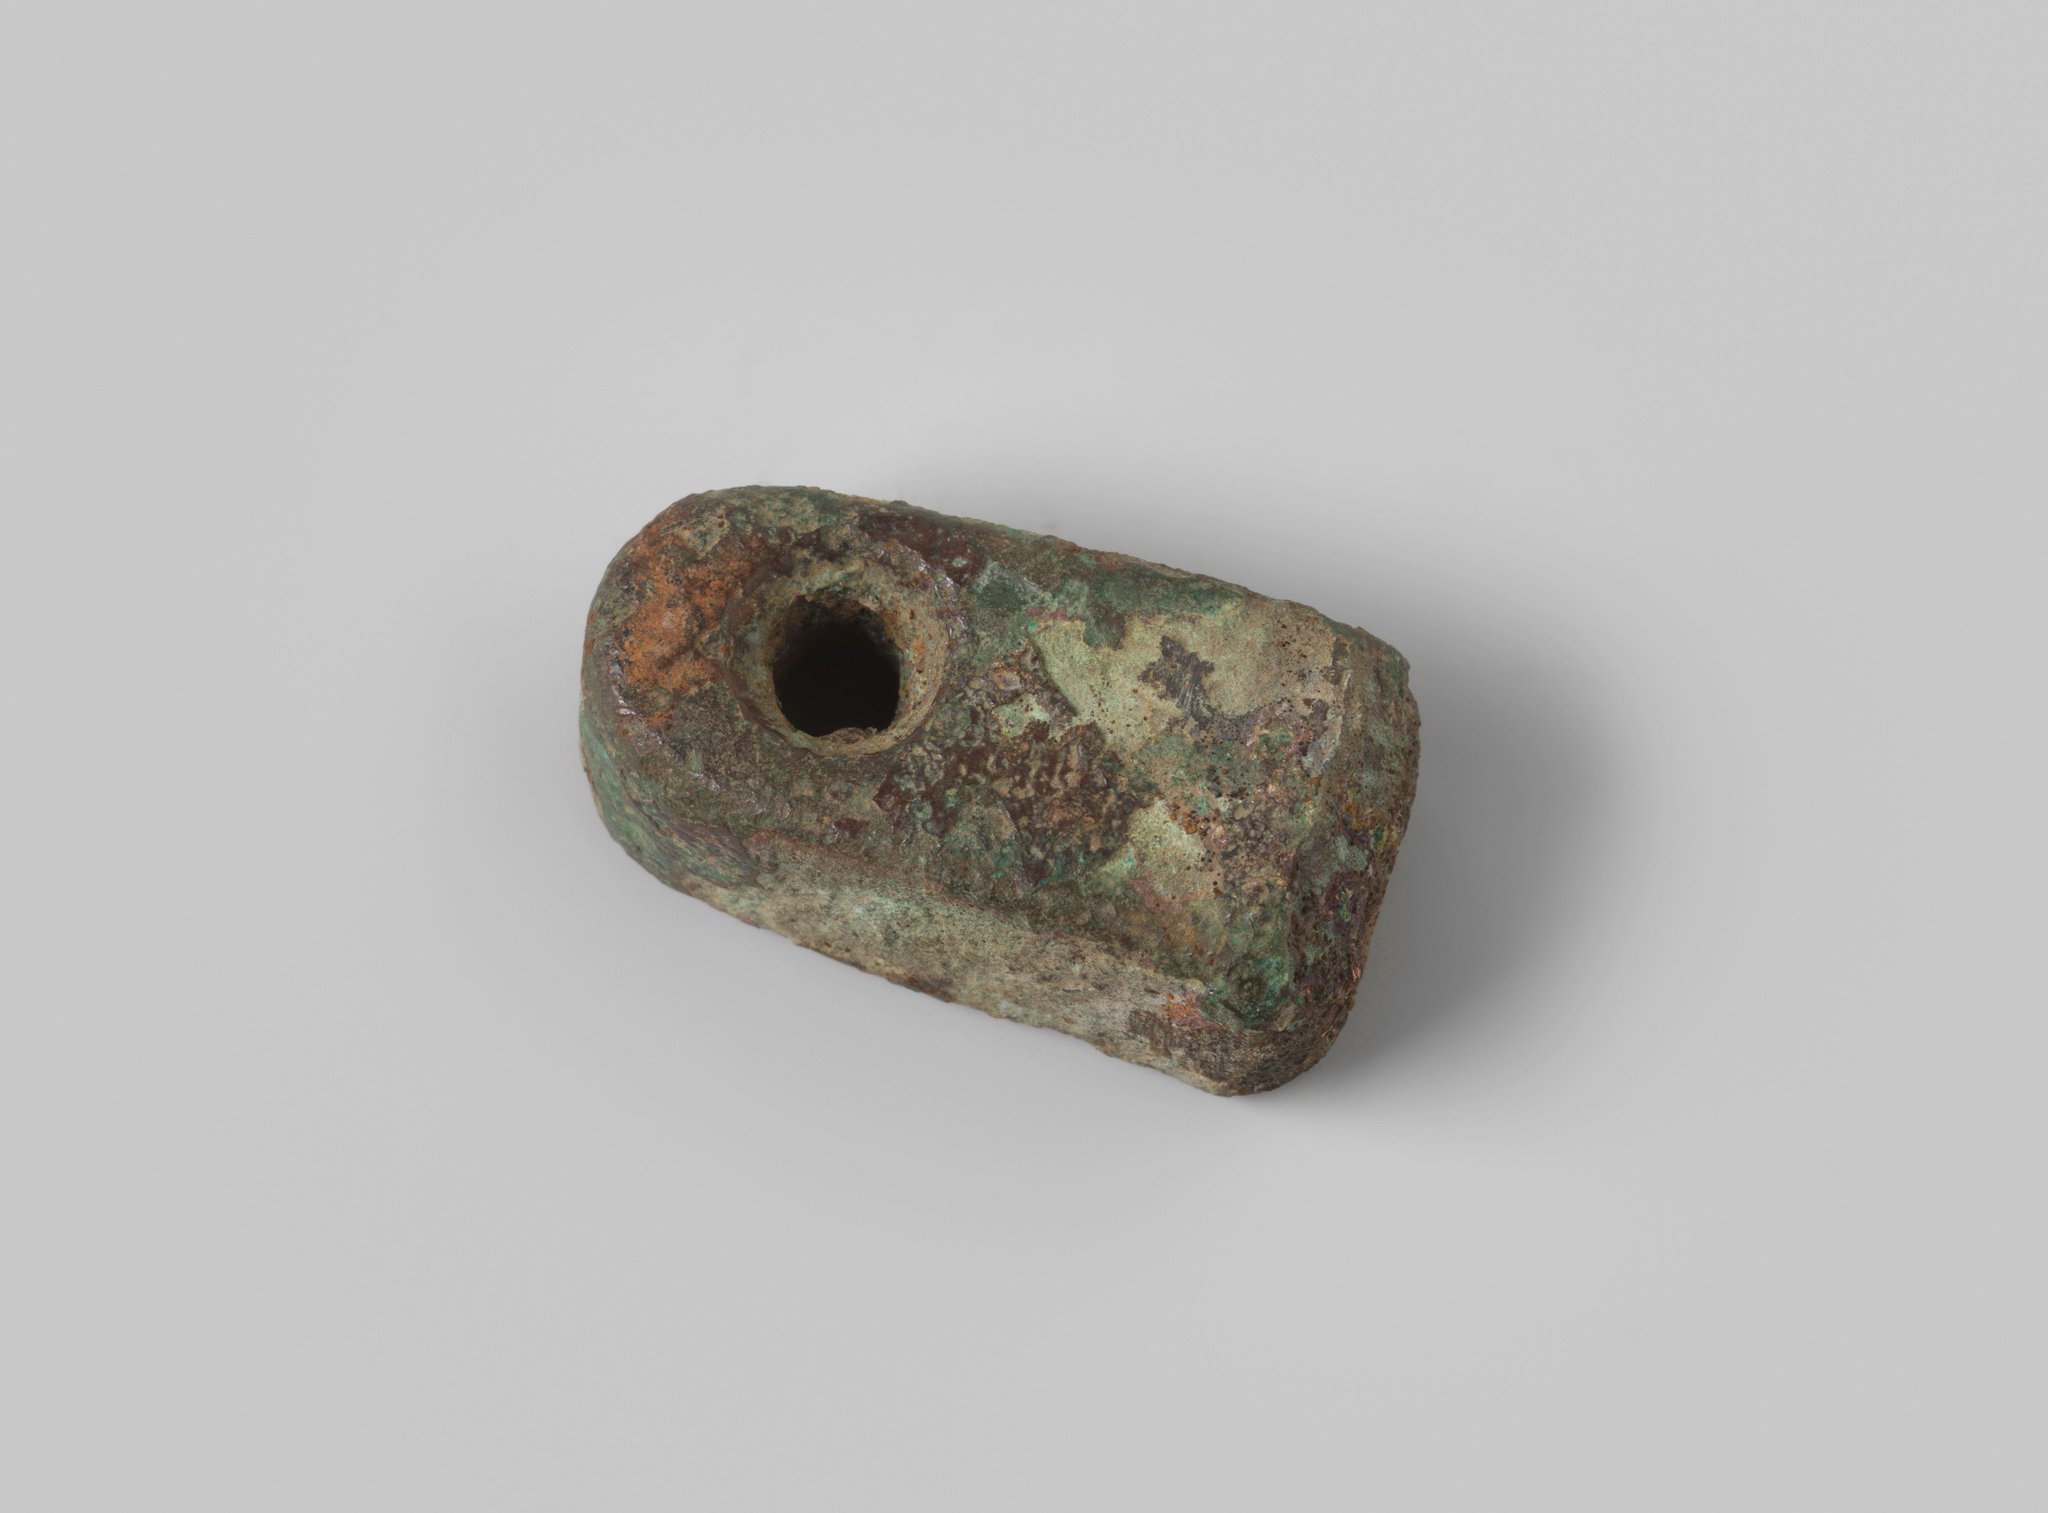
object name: block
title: Oog van katrol uit het wrak van de Oost-Indiëvaarder Hollandia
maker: Anonymous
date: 1700-1743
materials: copper, wood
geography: netherlands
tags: verenigde oostindische compagnie, hollandia (schip), annet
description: Block, sheave; fragm, id. NG 1980-27H2683, eroded, broken.